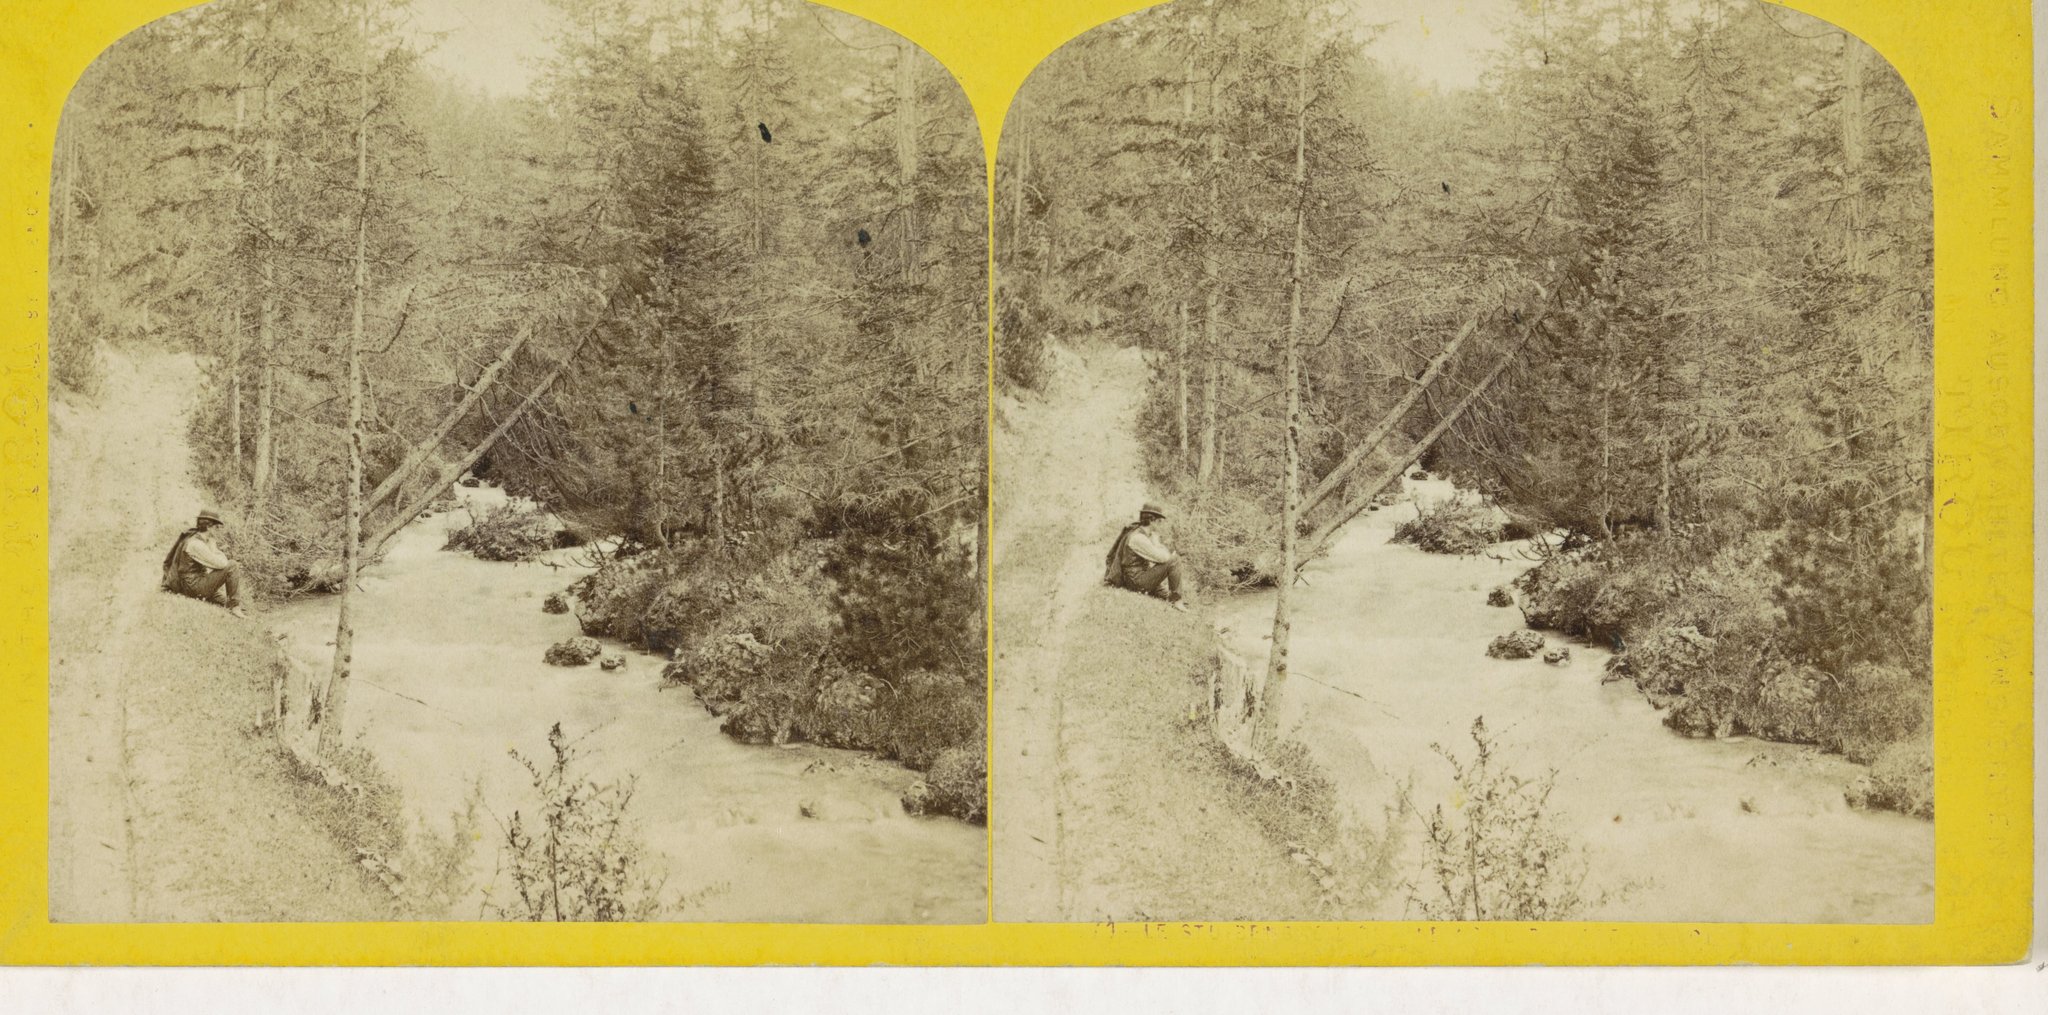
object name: stereograph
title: Zittende man bij de Stuibenbach, Tirol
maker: william england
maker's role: fotograaf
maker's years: 1816-1896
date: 1863-1865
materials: cardboard, paper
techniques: albumen print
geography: tirol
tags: brook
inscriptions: number: ‘71 [?]’, inscription: ‘M No 23’, inscription: ‘Tyrol’